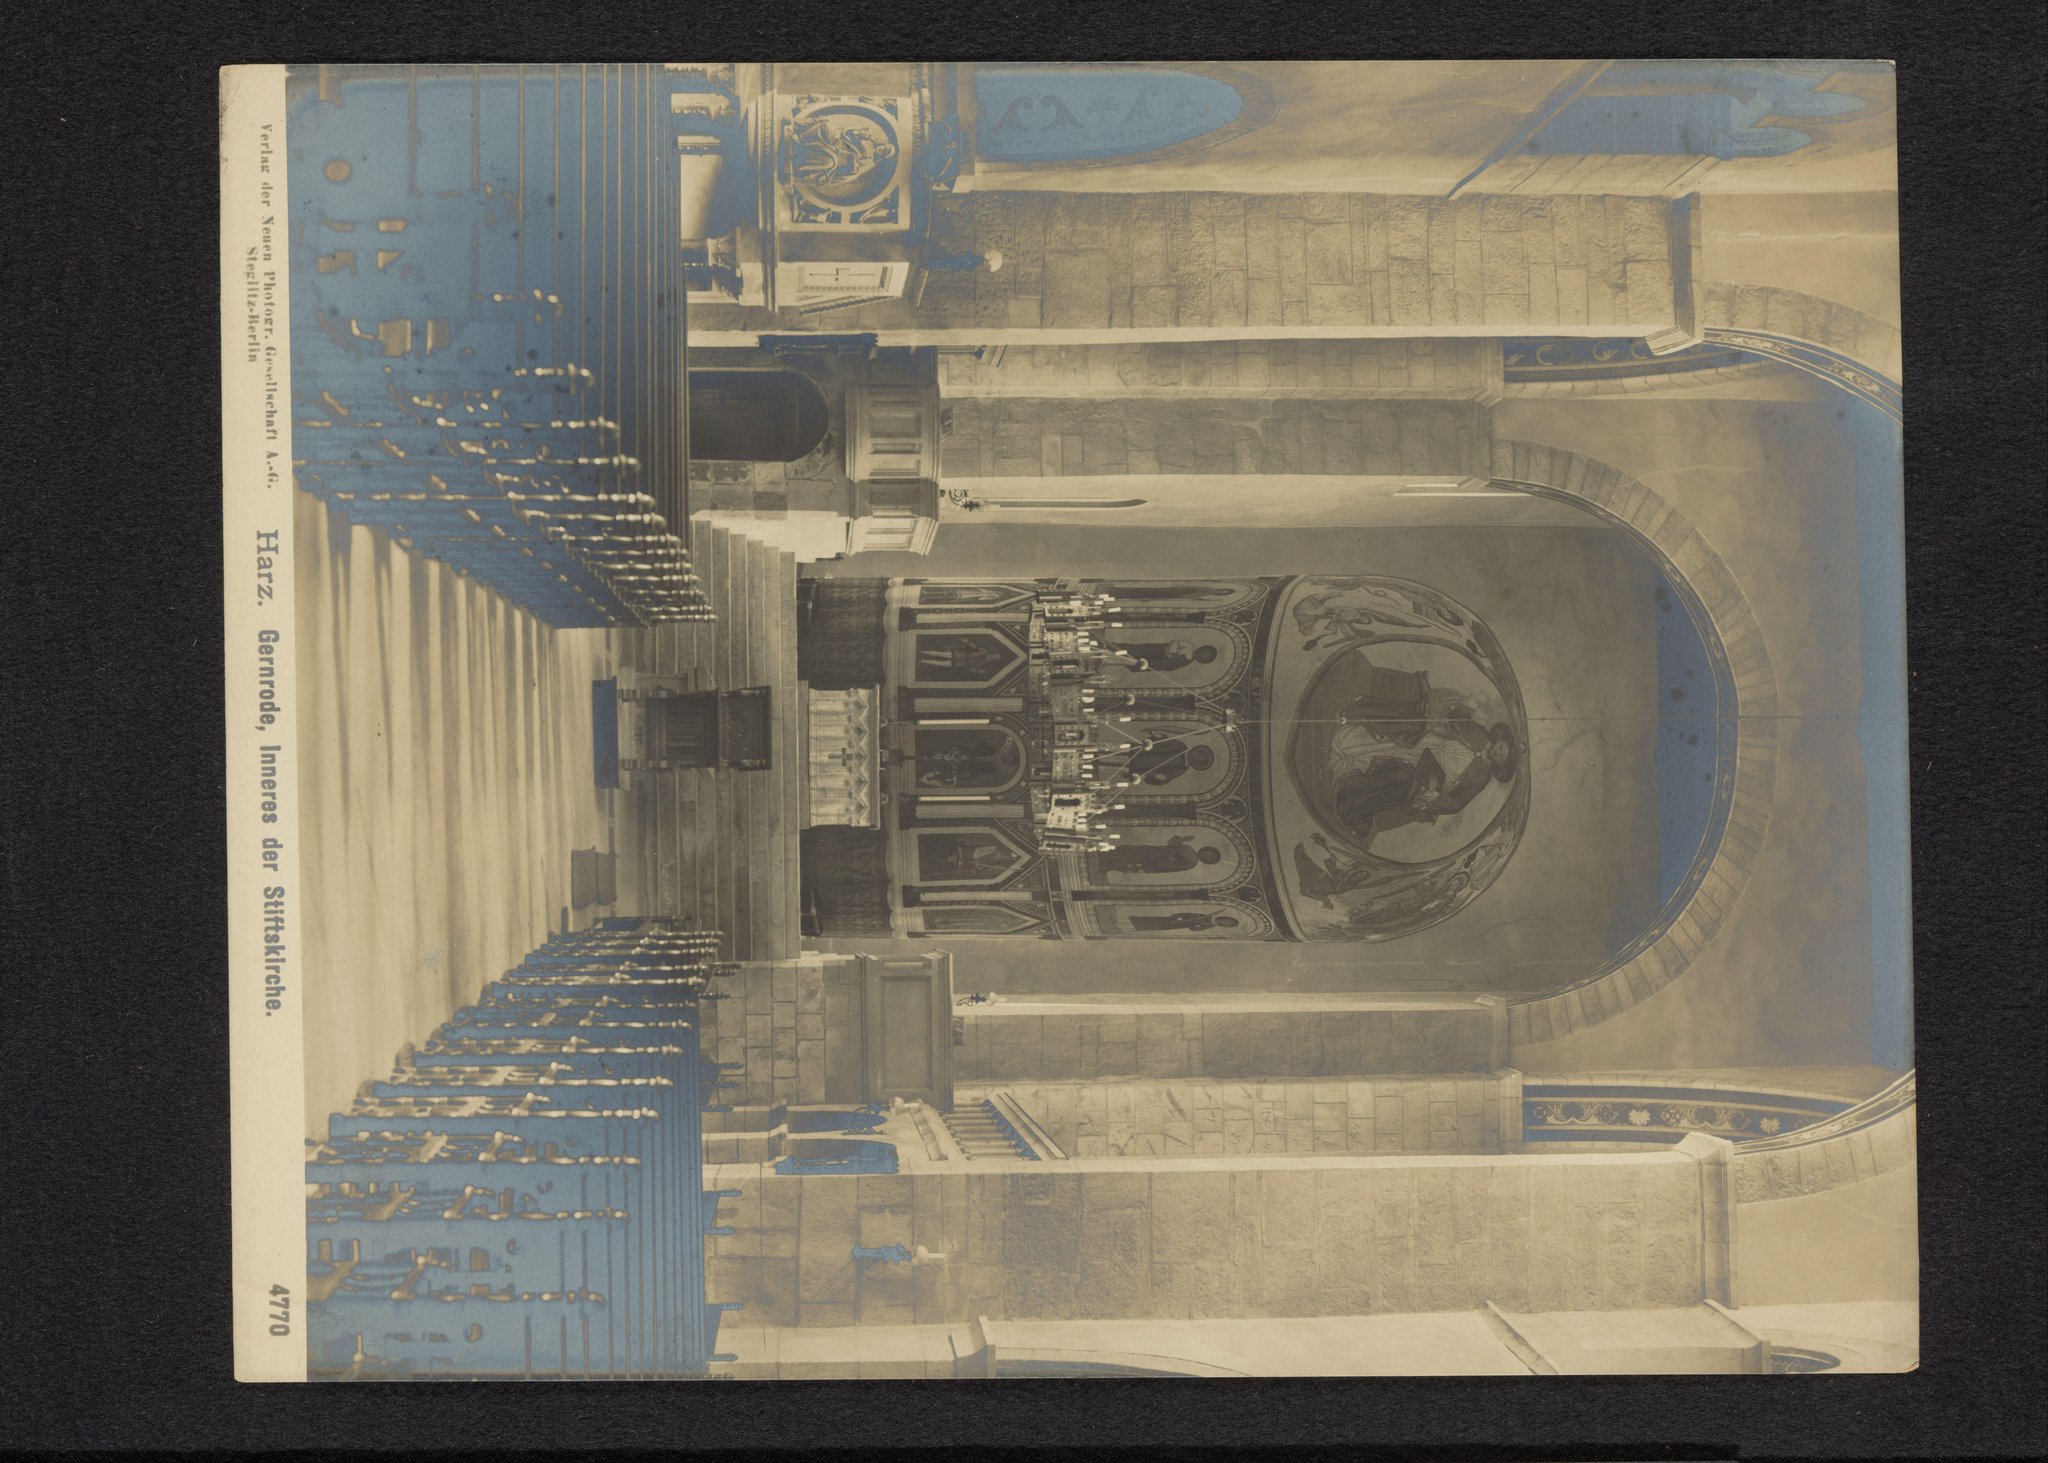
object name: photograph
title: Harz. Gernrode, Inneres der Stiftskirche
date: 1900-1911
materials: photographic support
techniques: gelatin silver print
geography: gernrode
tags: interior of church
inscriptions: number: ‘4770’